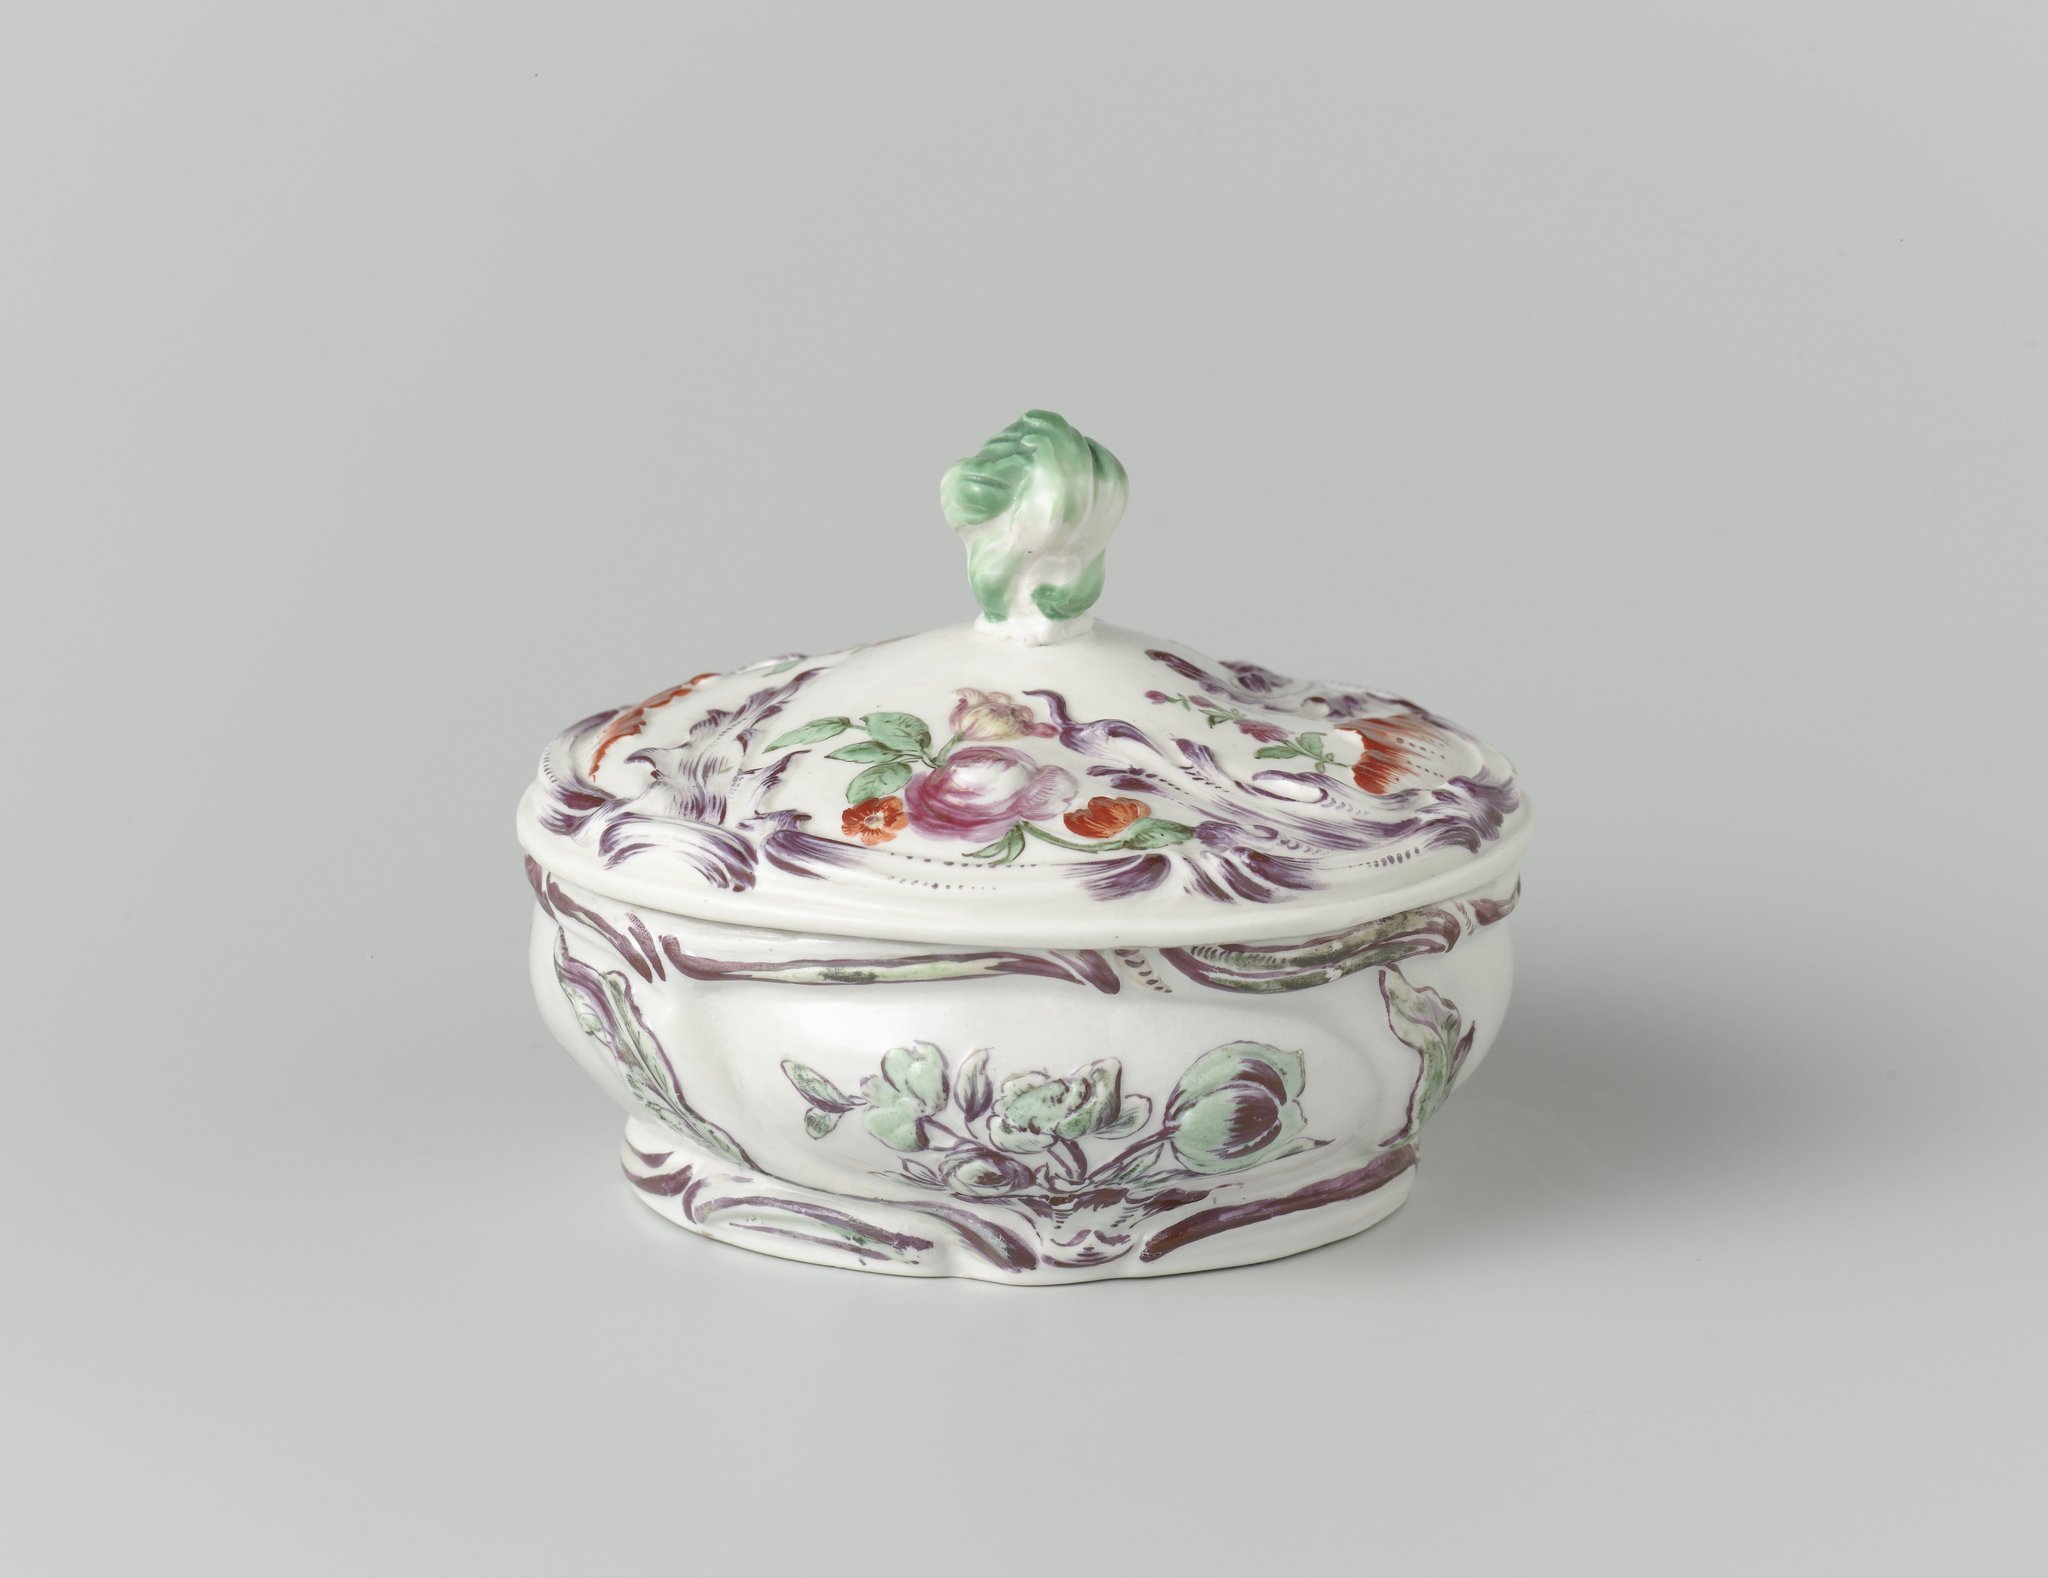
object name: tureen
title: Small tureen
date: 1760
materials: porcelain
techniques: painted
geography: weesp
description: Weesper porseleinfabriek Weesp, c. 1760 hard-paste porcelain